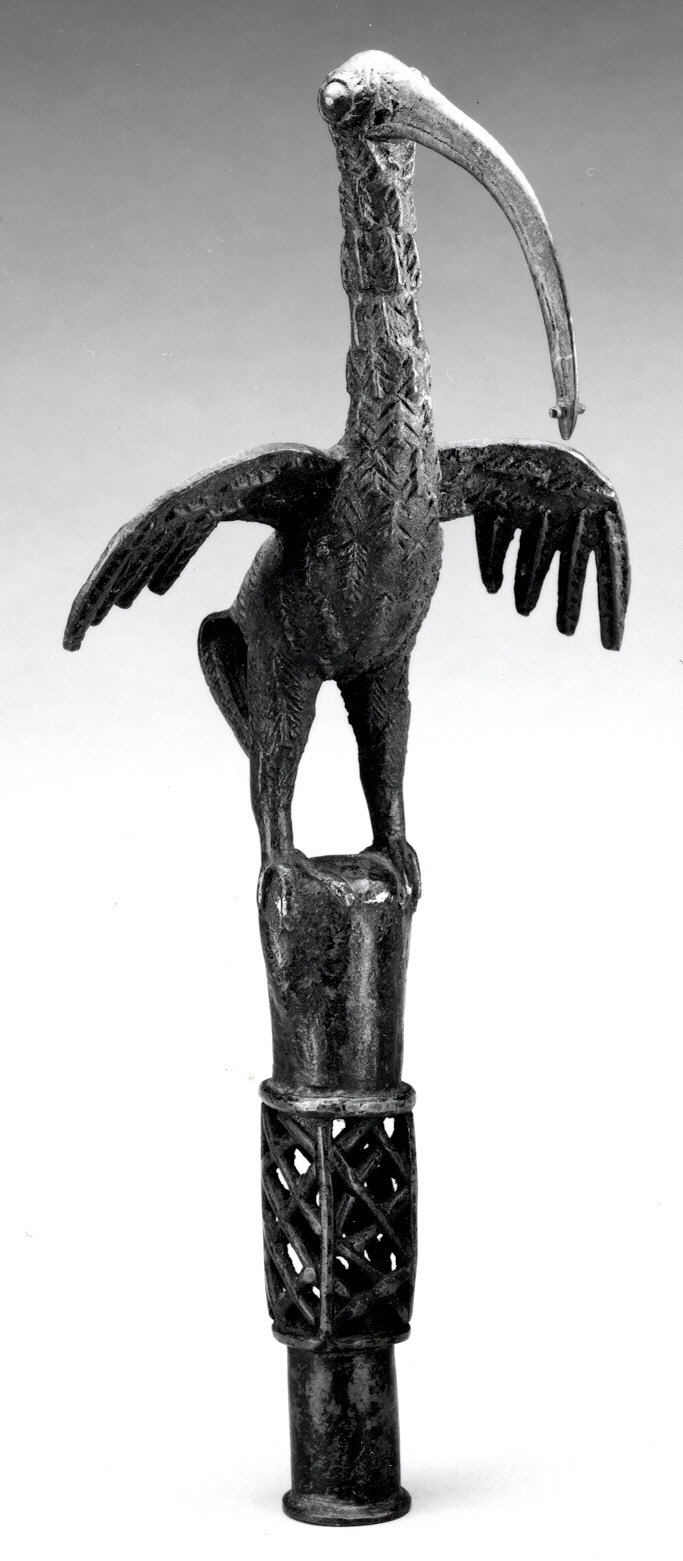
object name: idiophone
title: Idiophone: Bird of Prophecy (ahianmwen-oro)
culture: edo period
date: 1501-1900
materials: brass, iron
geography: nigeria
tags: birds